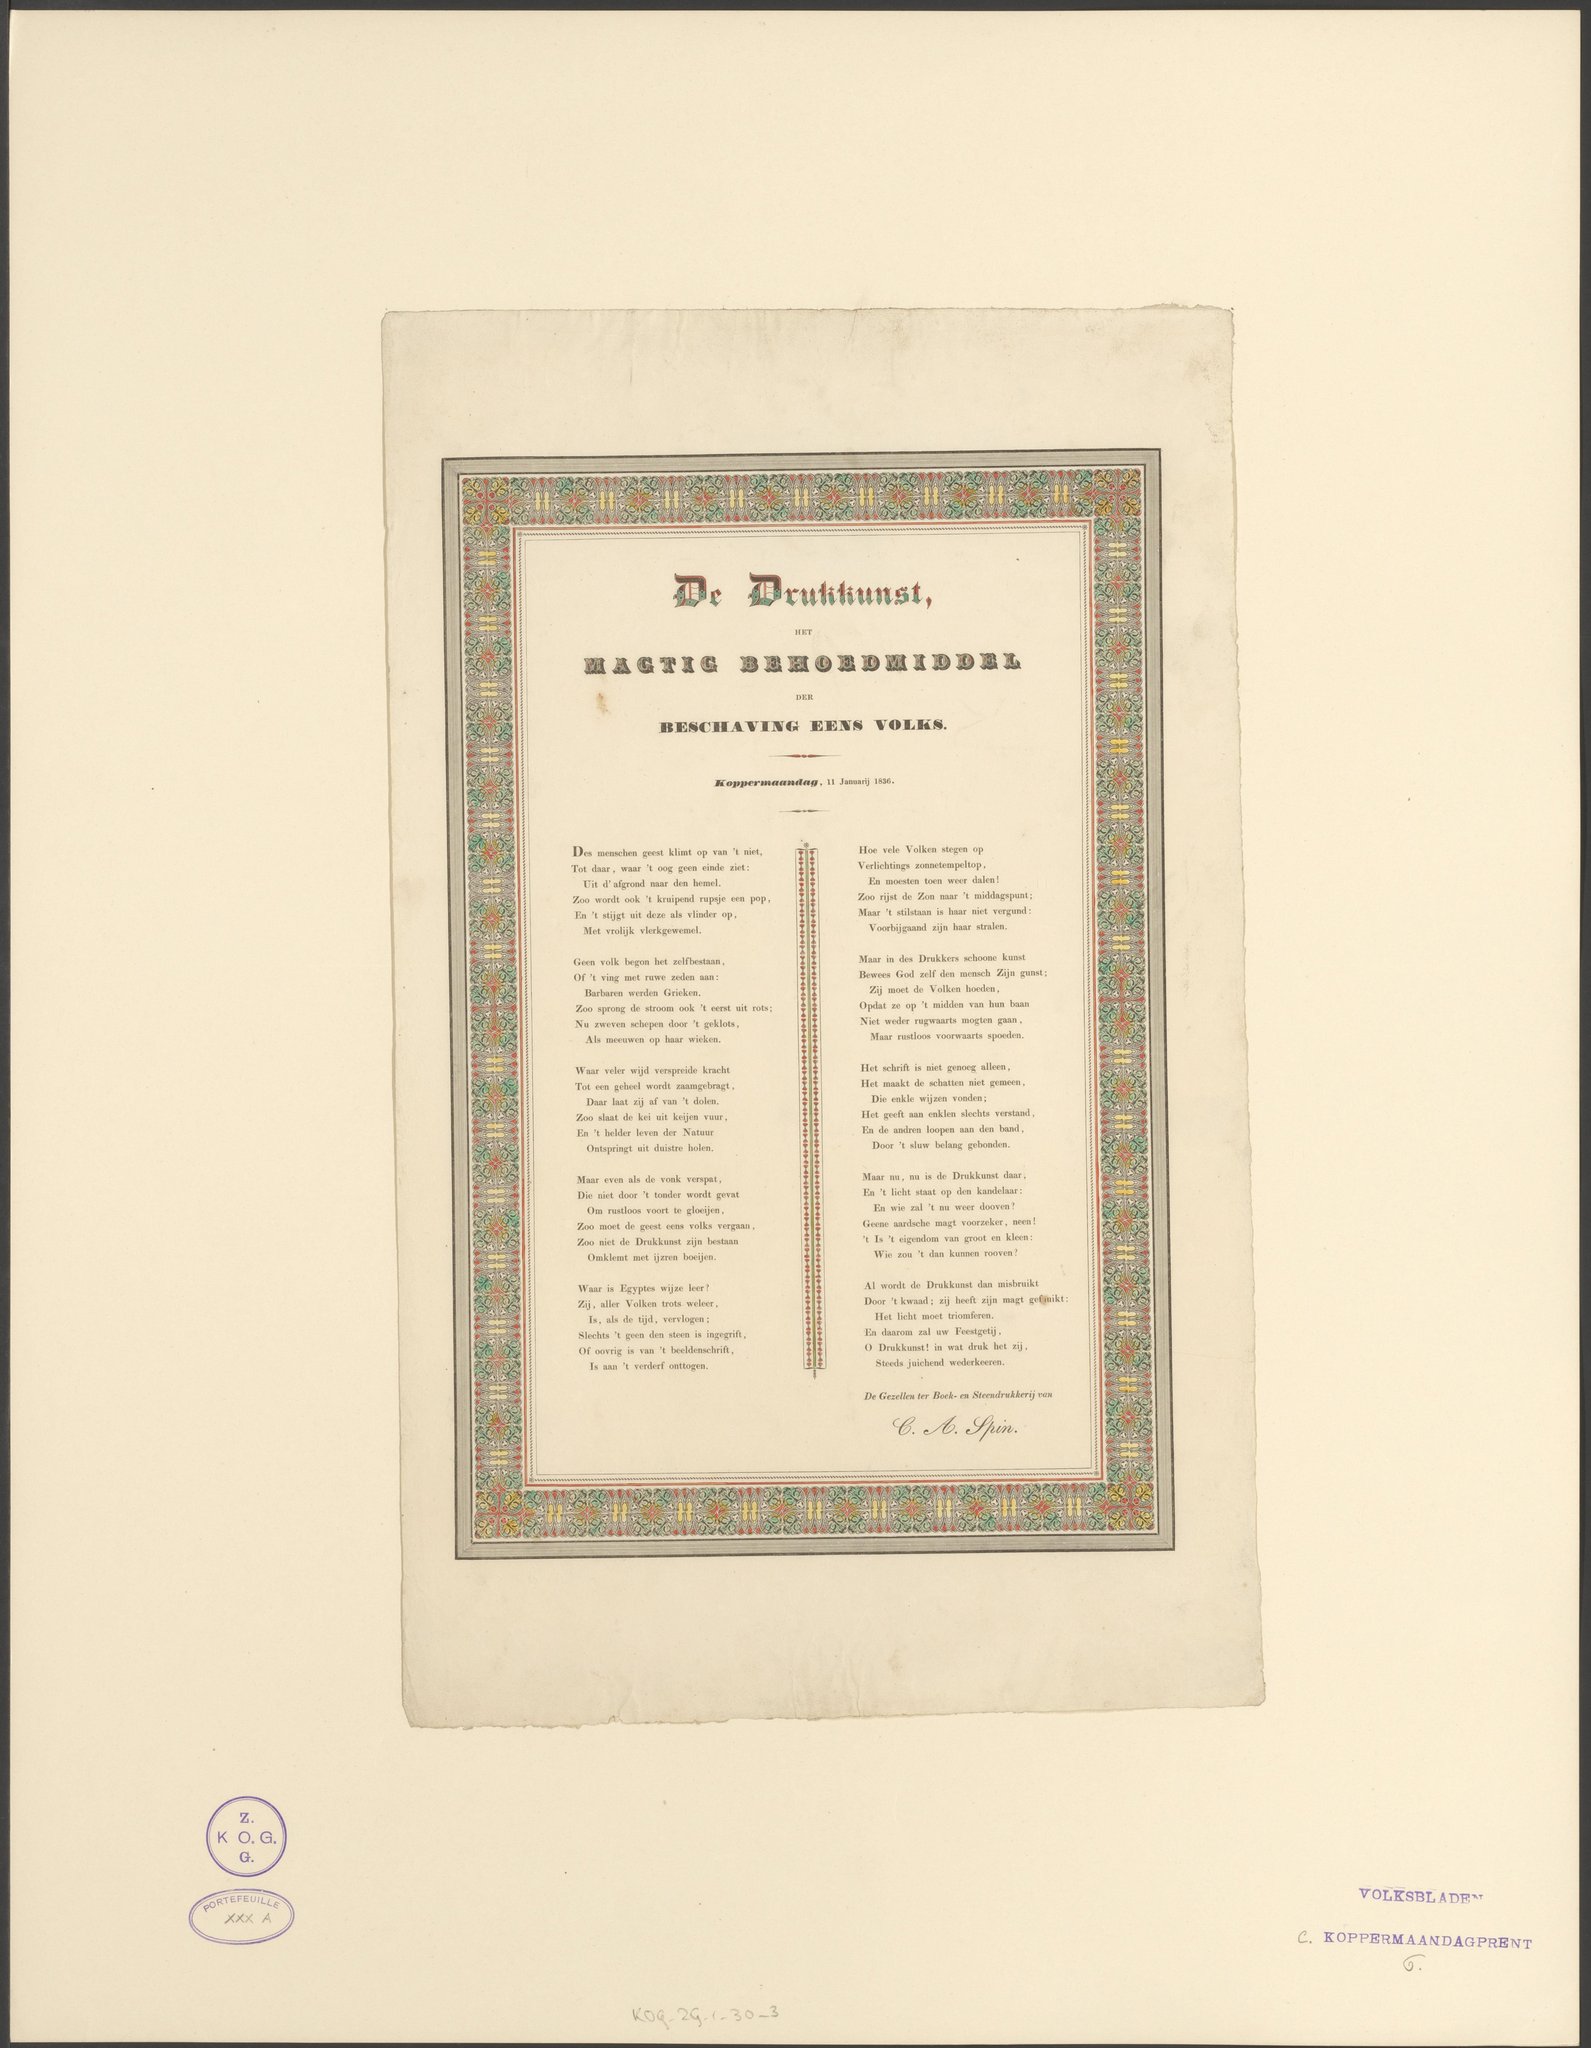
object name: text sheet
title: Lofzang op de boekdrukkunst en de beschaving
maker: christiaan andersen spin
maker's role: printer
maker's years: 1792-1865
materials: paper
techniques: hand coloring, letterpress printing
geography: amsterdam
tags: printing press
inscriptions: stamp, collector's mark: Lugt 1641, stamp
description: Koppermaandagprent met lofzang op de boekdrukkunst en de beschaving, voor koppermaandag 11 januari 1836. Met een vers in twee kolommen. Onderwerpsrubrieken binnen de Atlas Zeden en Gewoonten: Zeden en Gewoonten in engeren zin. Volksleven. Volksbladen. Koppermaandagwenschen.